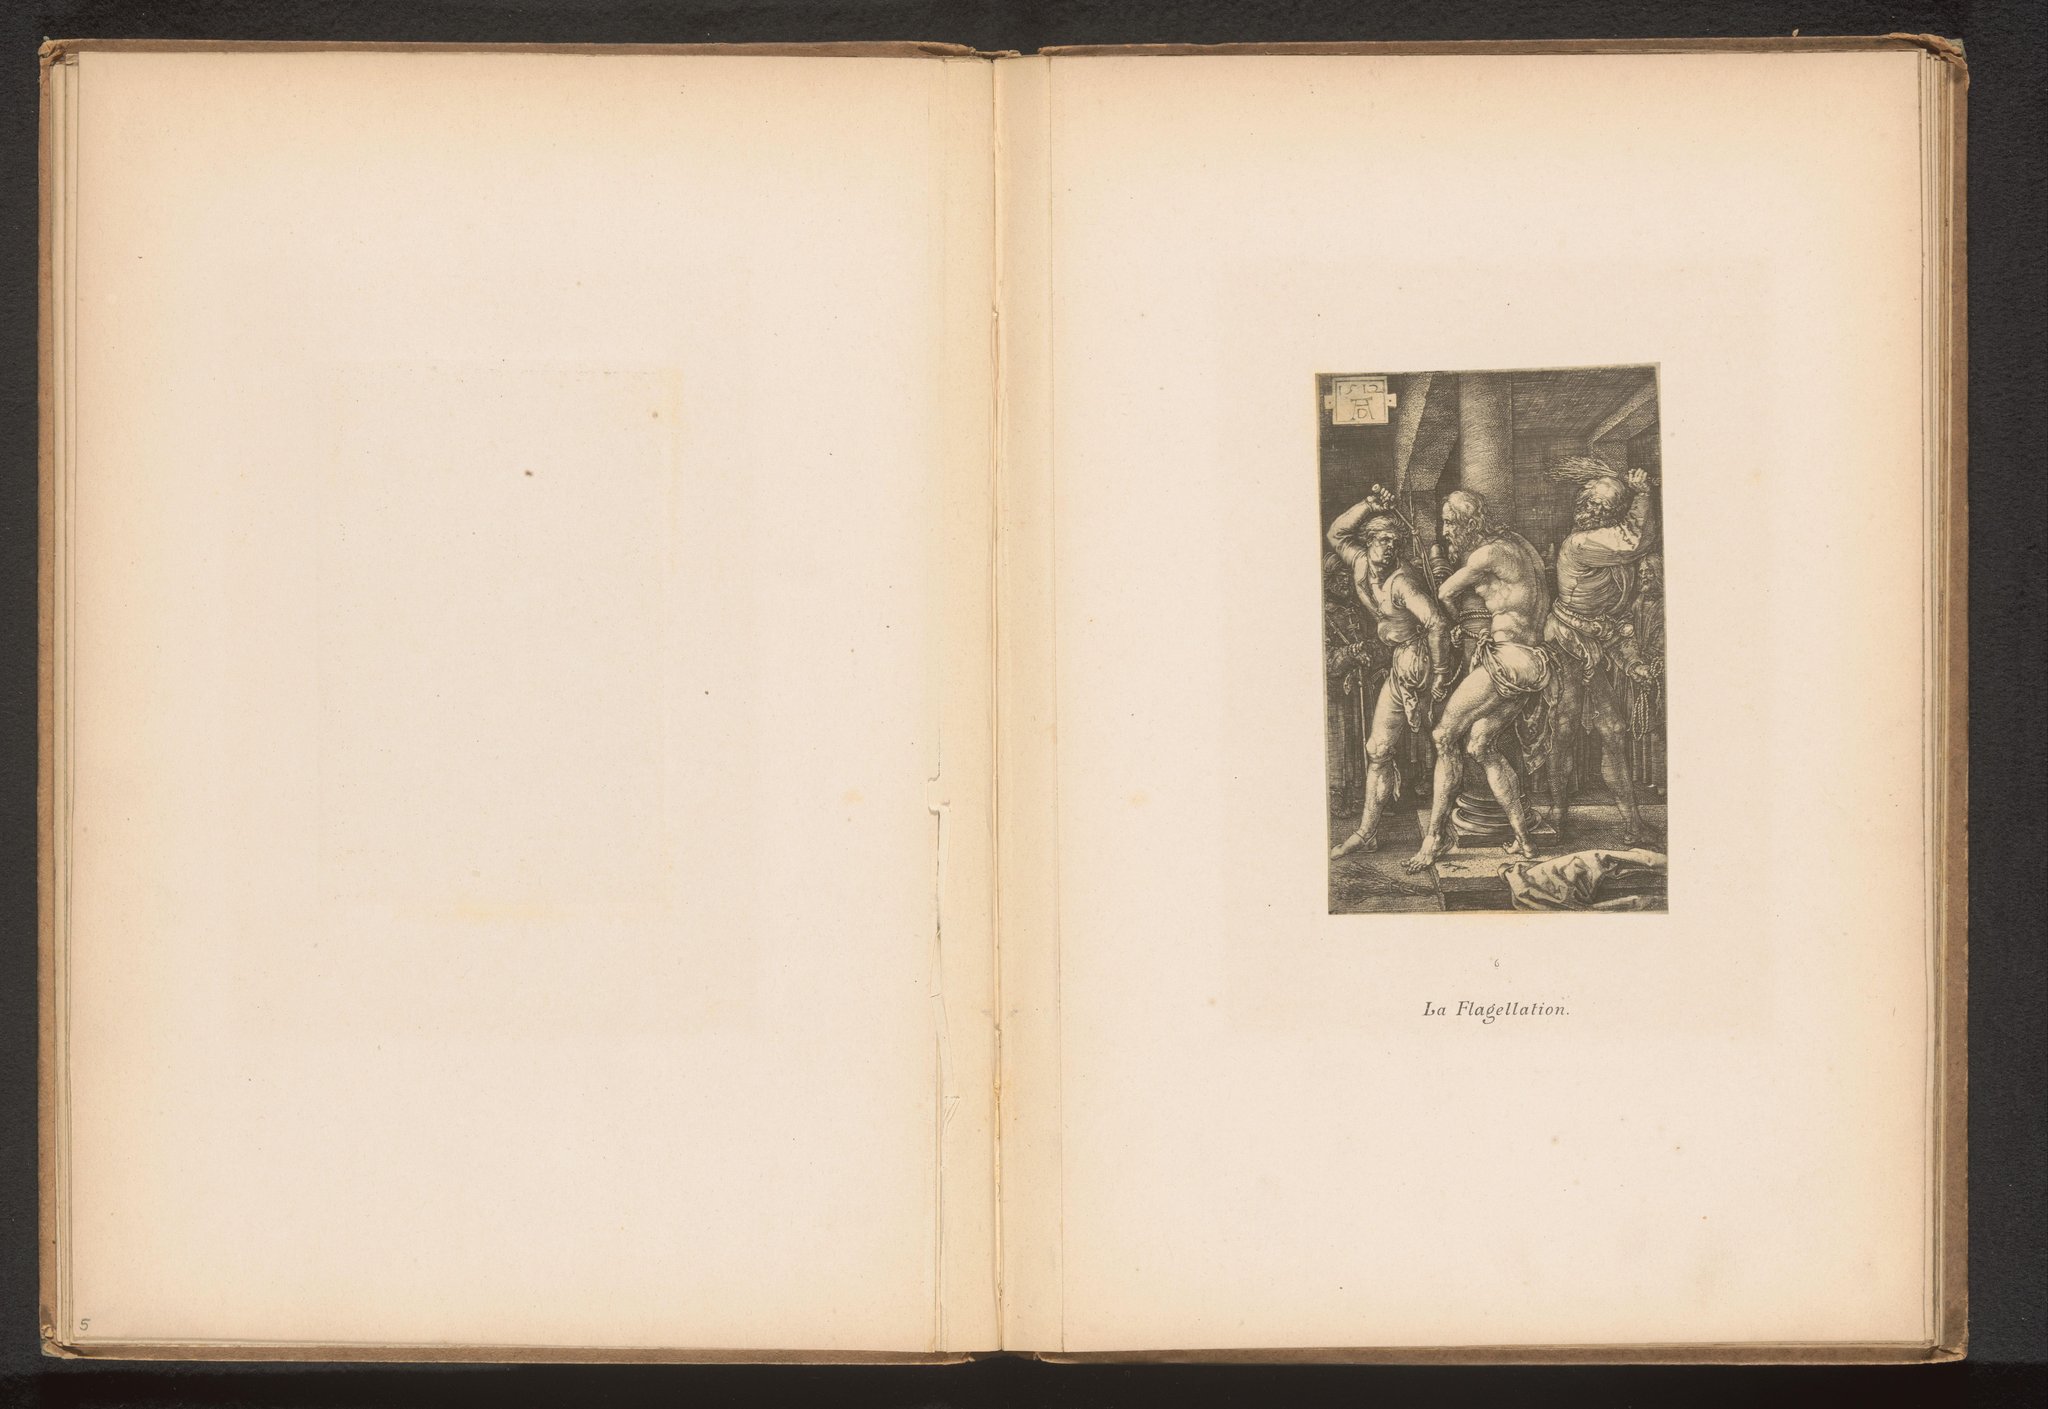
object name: page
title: La Flagellation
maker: albrecht dürer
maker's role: draughtsman, painter, print maker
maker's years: 1471-1528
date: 1866-1871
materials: paper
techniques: woodburytype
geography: nuremberg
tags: passion of christ, flagellation by soldiers, christ usually tied to a column (matthew 27:26; mark 15:15; john 19:1)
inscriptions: number: ‘6’